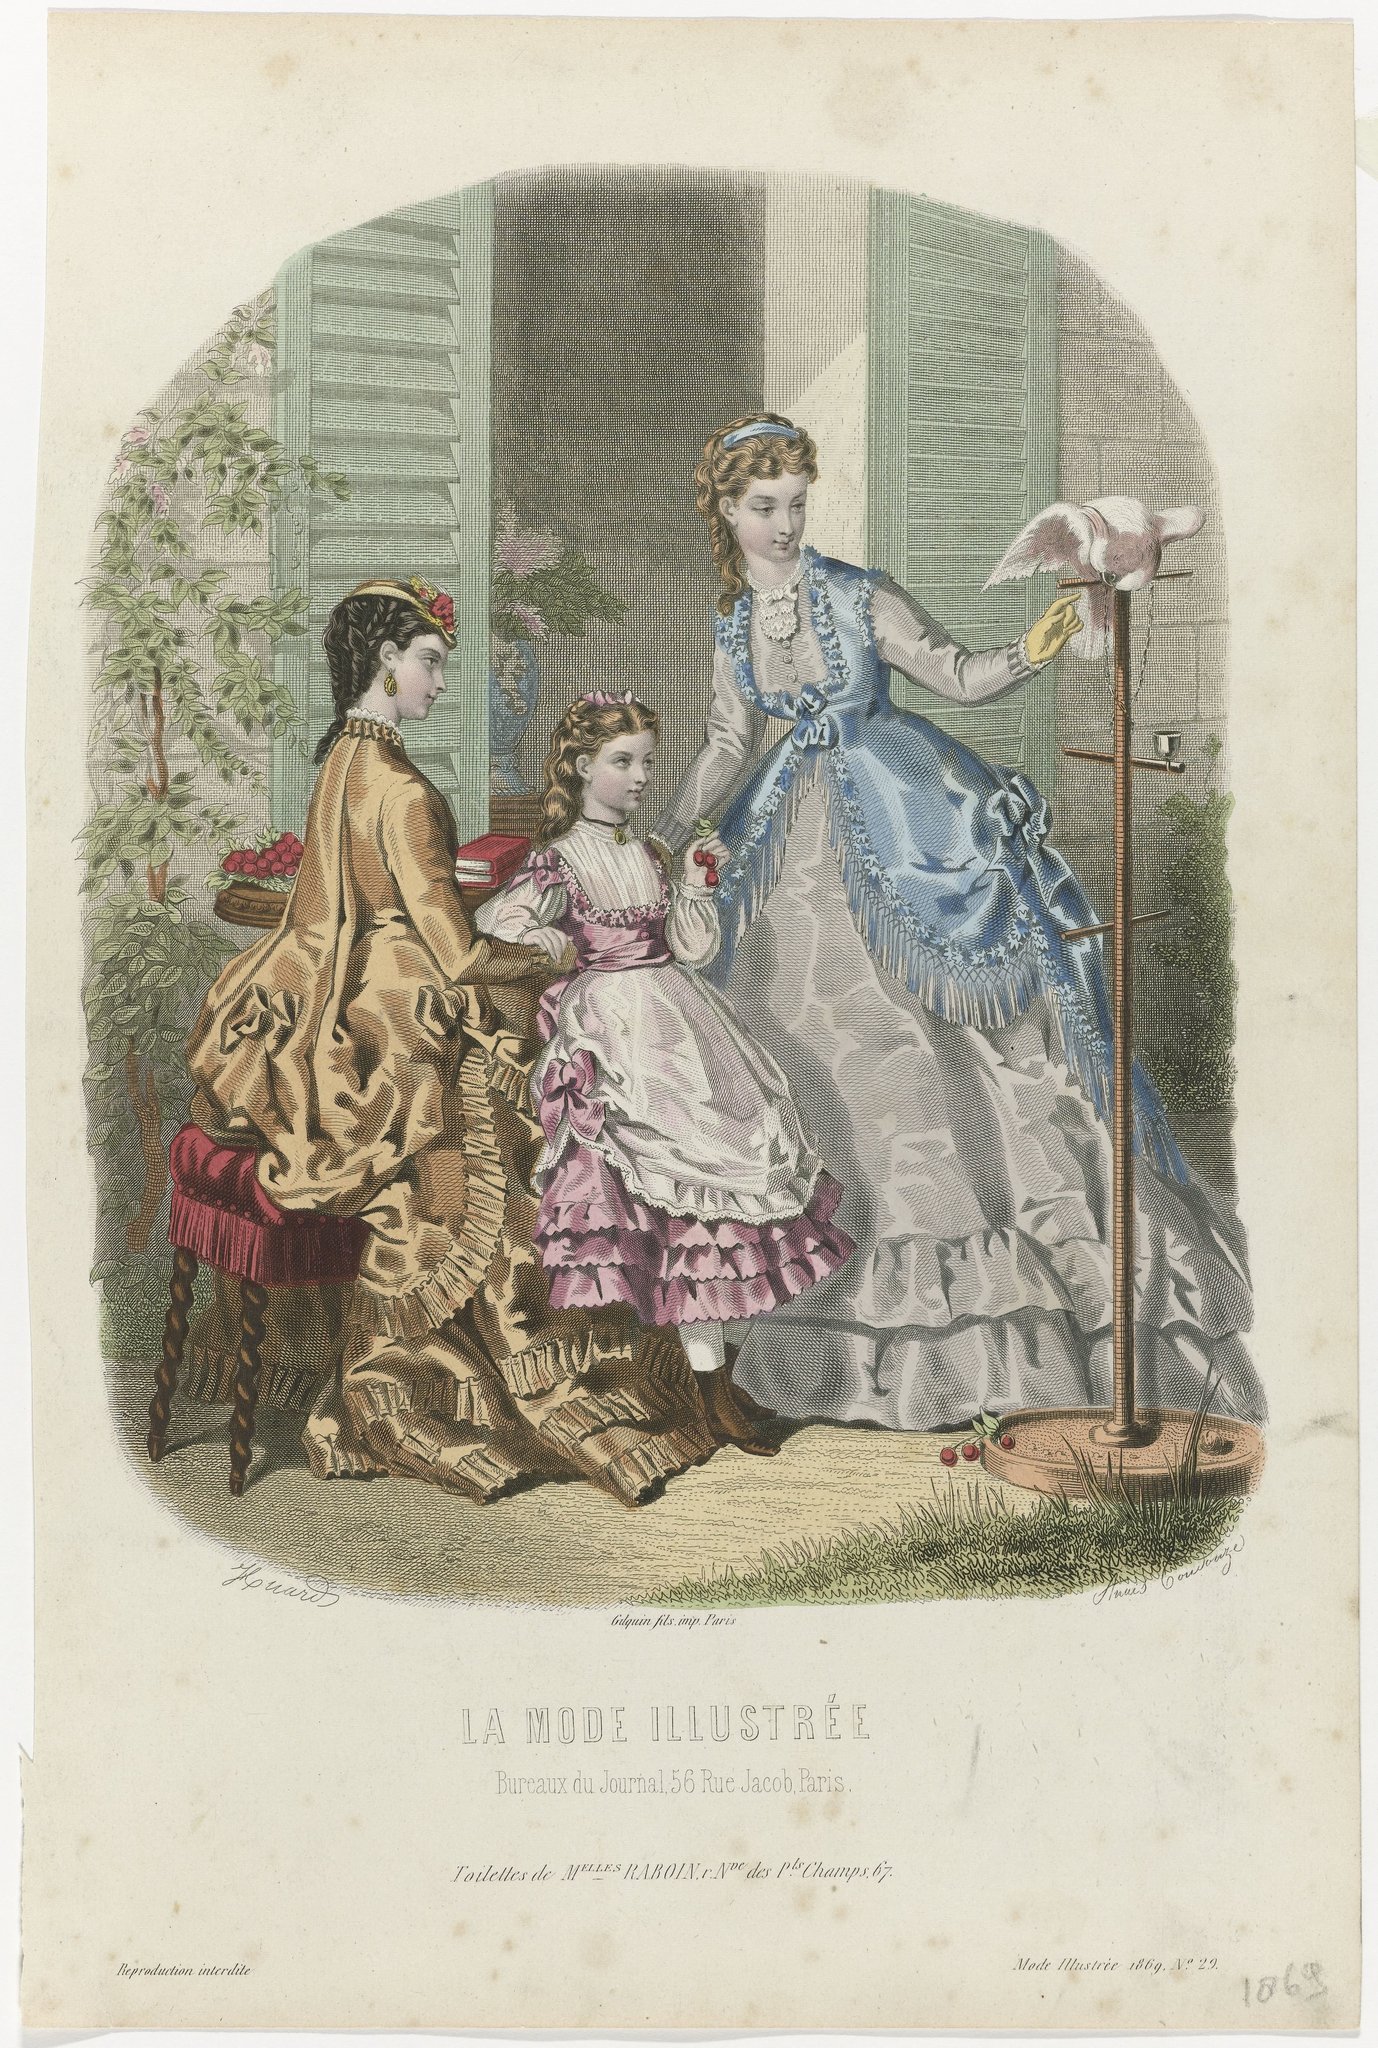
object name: fashion print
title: La Mode Illustrée, 1869, No. 29: Toilettes de Melles Raboin (...)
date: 1869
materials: paper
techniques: engraving, hand coloring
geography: paris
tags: ear-rings (+ women's clothes), boots (+ girls' clothes), pendant, trinket, 'breloque' (+ girls' clothes), head-gear (+ women's clothes), ornamental birds: parrot, fashion plates, dress, gown (+ women's clothes), fruits: cherry, dress, gown (+ girls' clothes)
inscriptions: caption: ‘Toilettes de M.elles Raboin. r. Nve des P.ts Champs. 67.’, address: ‘Bureaux du Journal, 56, Rue Jacob. Paris’, title: ‘La Mode Illustrée’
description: Twee vrouwen en een meisje in een tuin, kijken naar een papegaai op een standaard. Volgens het onderschrift: ensembles van Raboin. Prent uit het modetijdschrift La Mode Illustrée (1860-1937).